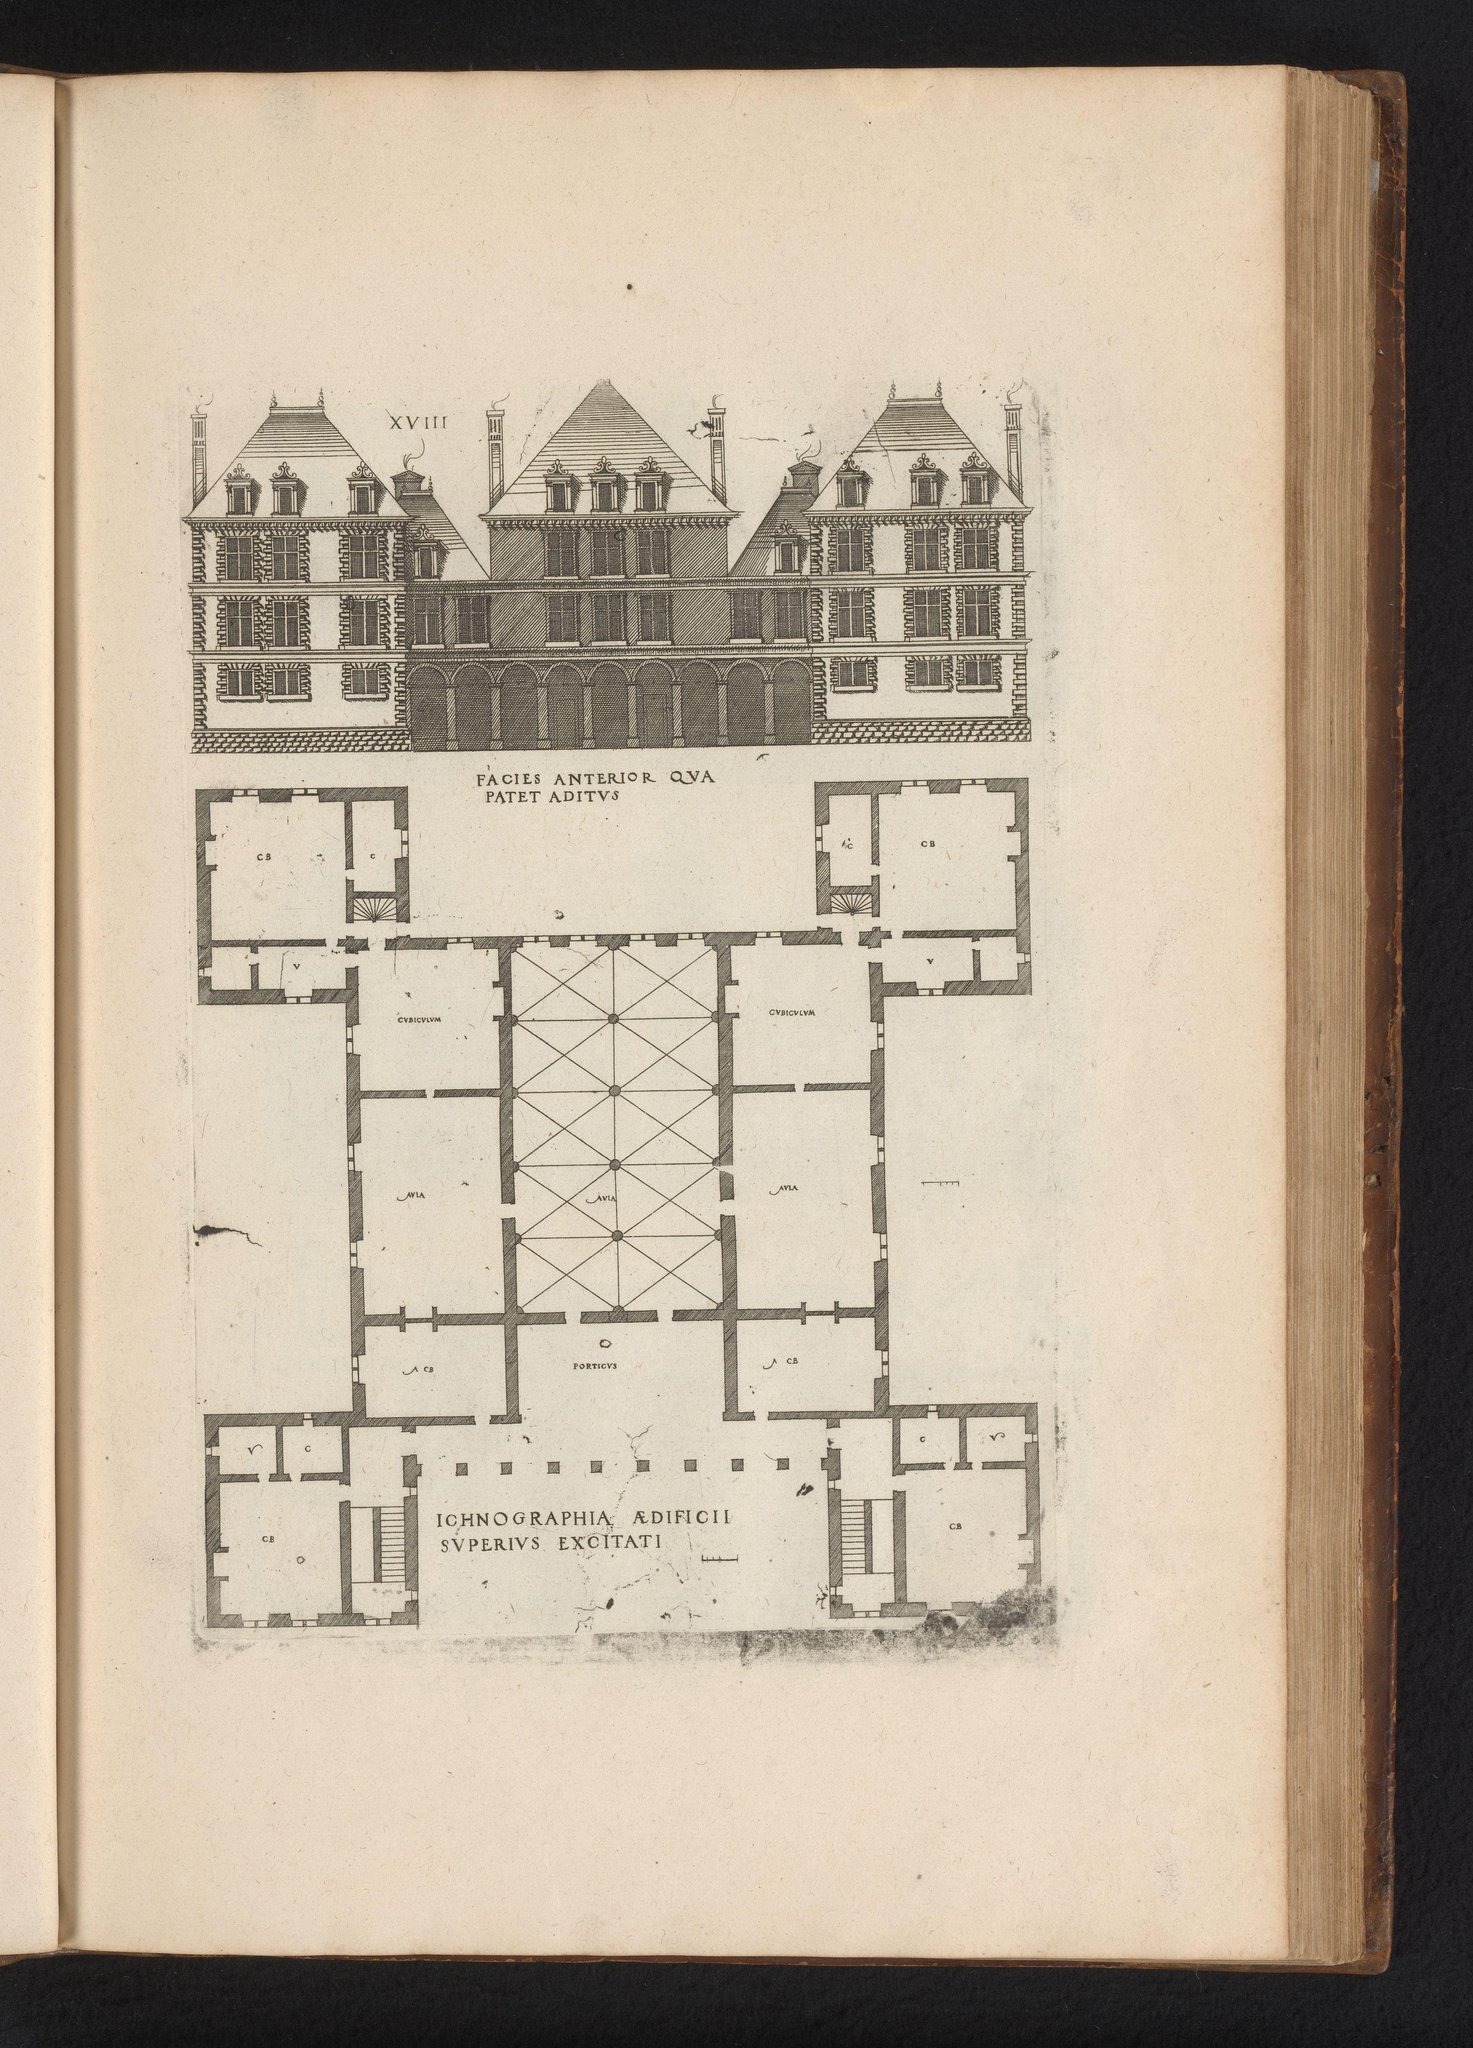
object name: ornament print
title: Voorgevel en plattegrond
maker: jacques androuet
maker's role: draughtsman, print maker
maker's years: 1515-1584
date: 1559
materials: paper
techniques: etching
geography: paris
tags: façade (of house or building), plan ~ architecture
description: Voorgevel en plattegrond. Aanzicht en plattegrond van architectuur. Genummerd: XVIII. Onderdeel van 'De architectura Iacobi Androuetii du Cerceau' (1559): 69 etsen met 171 voorstellingen van architectuur en ornamentiek.